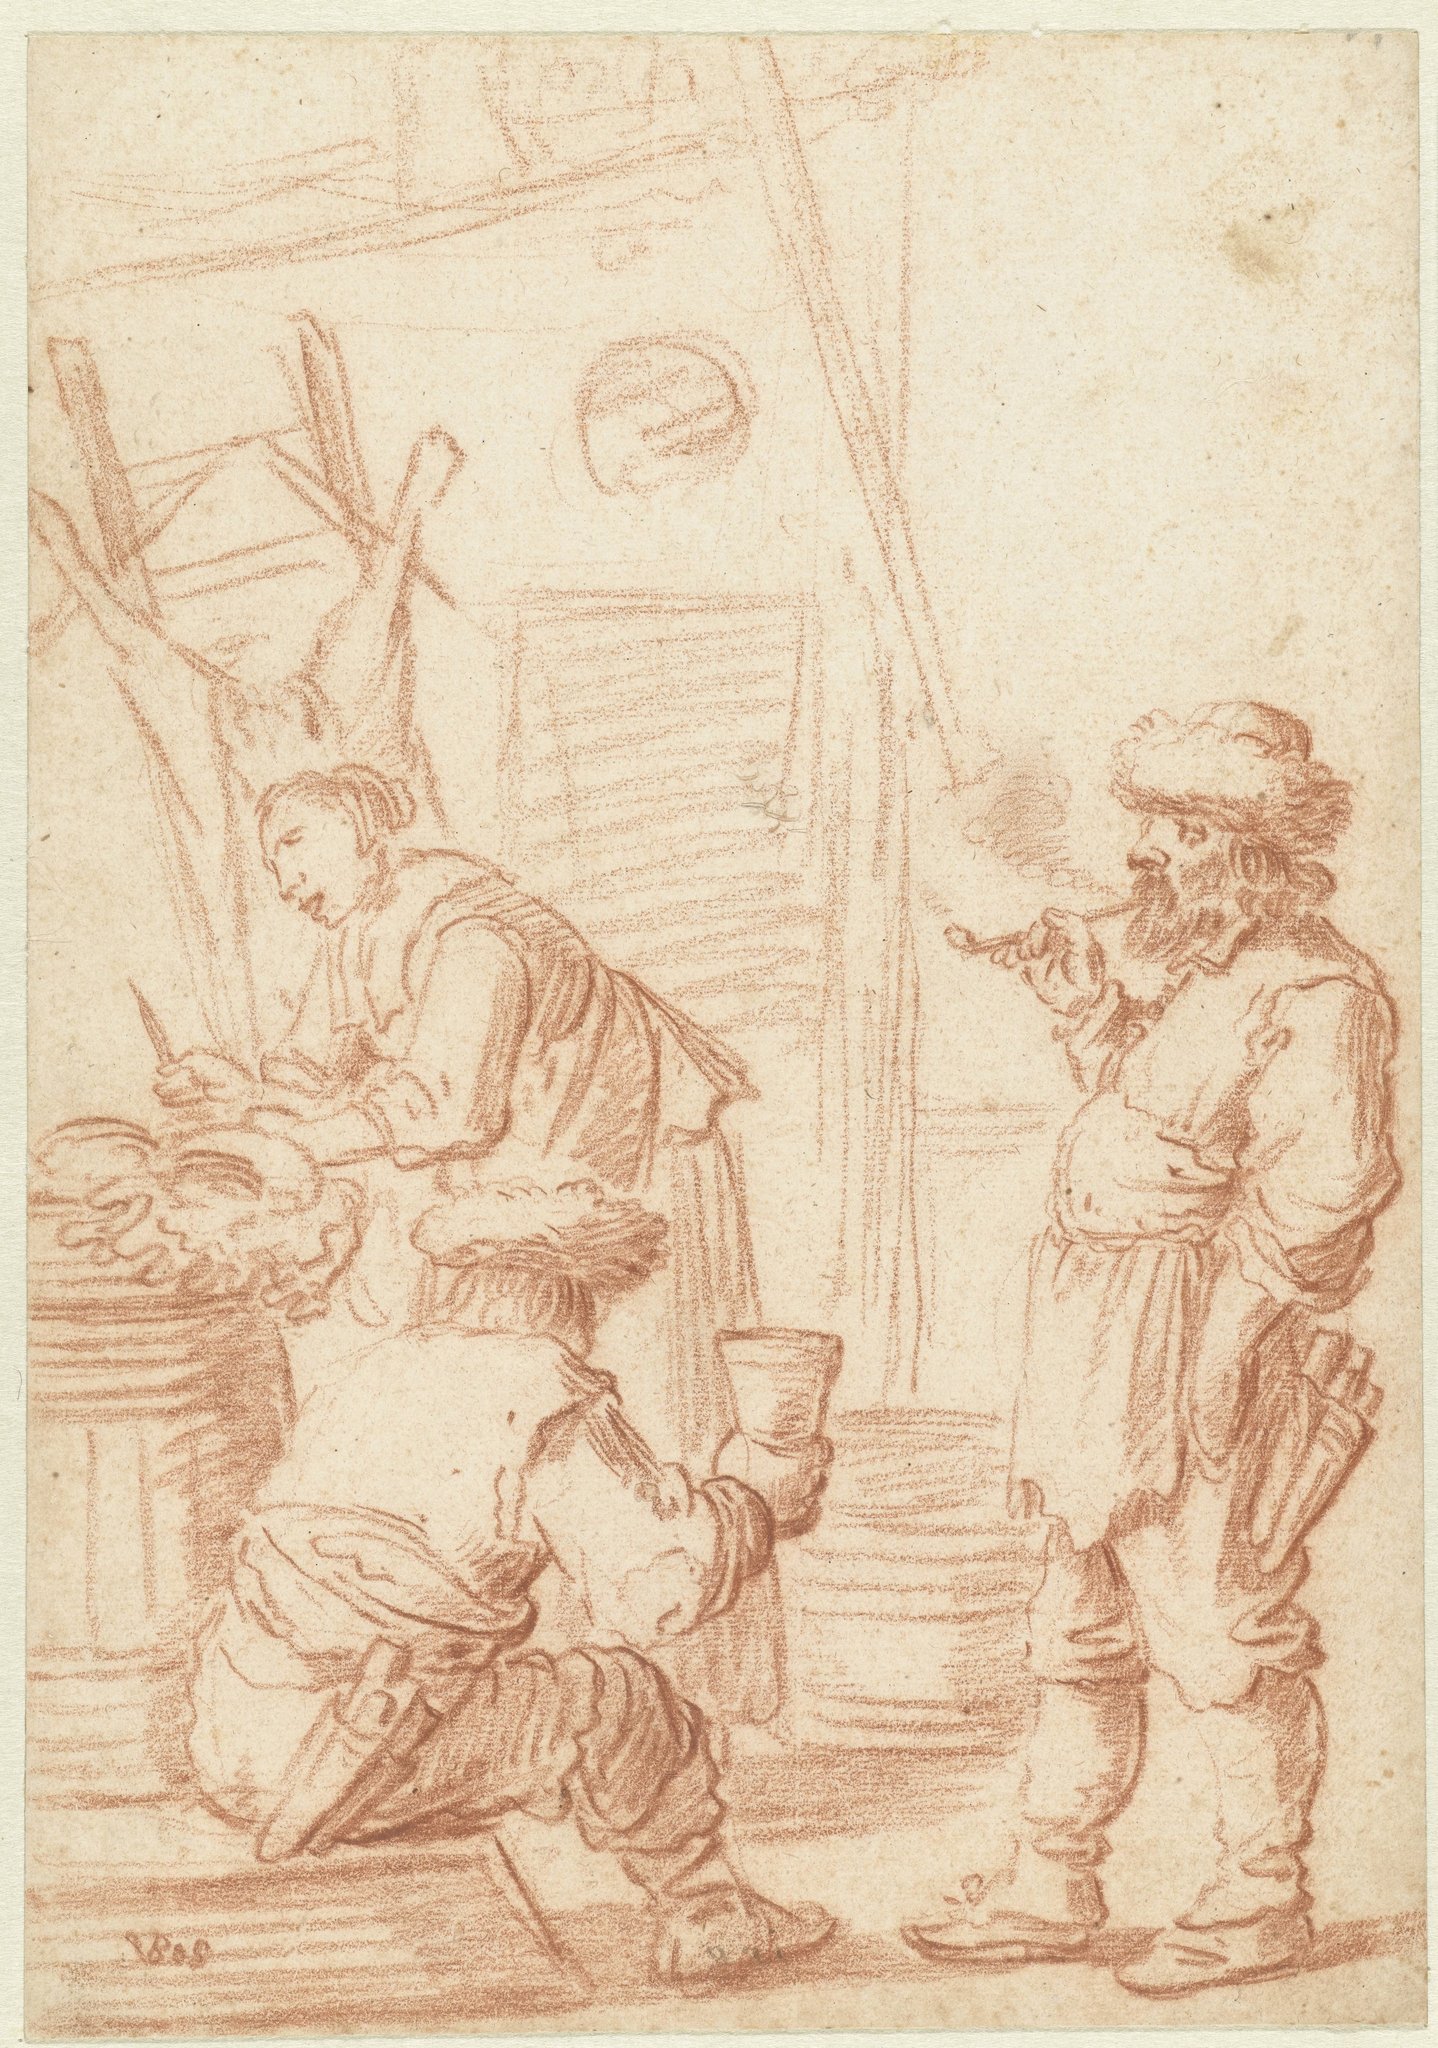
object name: drawing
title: Interieur van een slagerij met een vrouwelijke en twee mannelijke figuren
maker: pieter van den bos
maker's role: draughtsman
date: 1623-1663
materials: chalk, paper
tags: slaughtered ox or pig, butcher, slaughterman